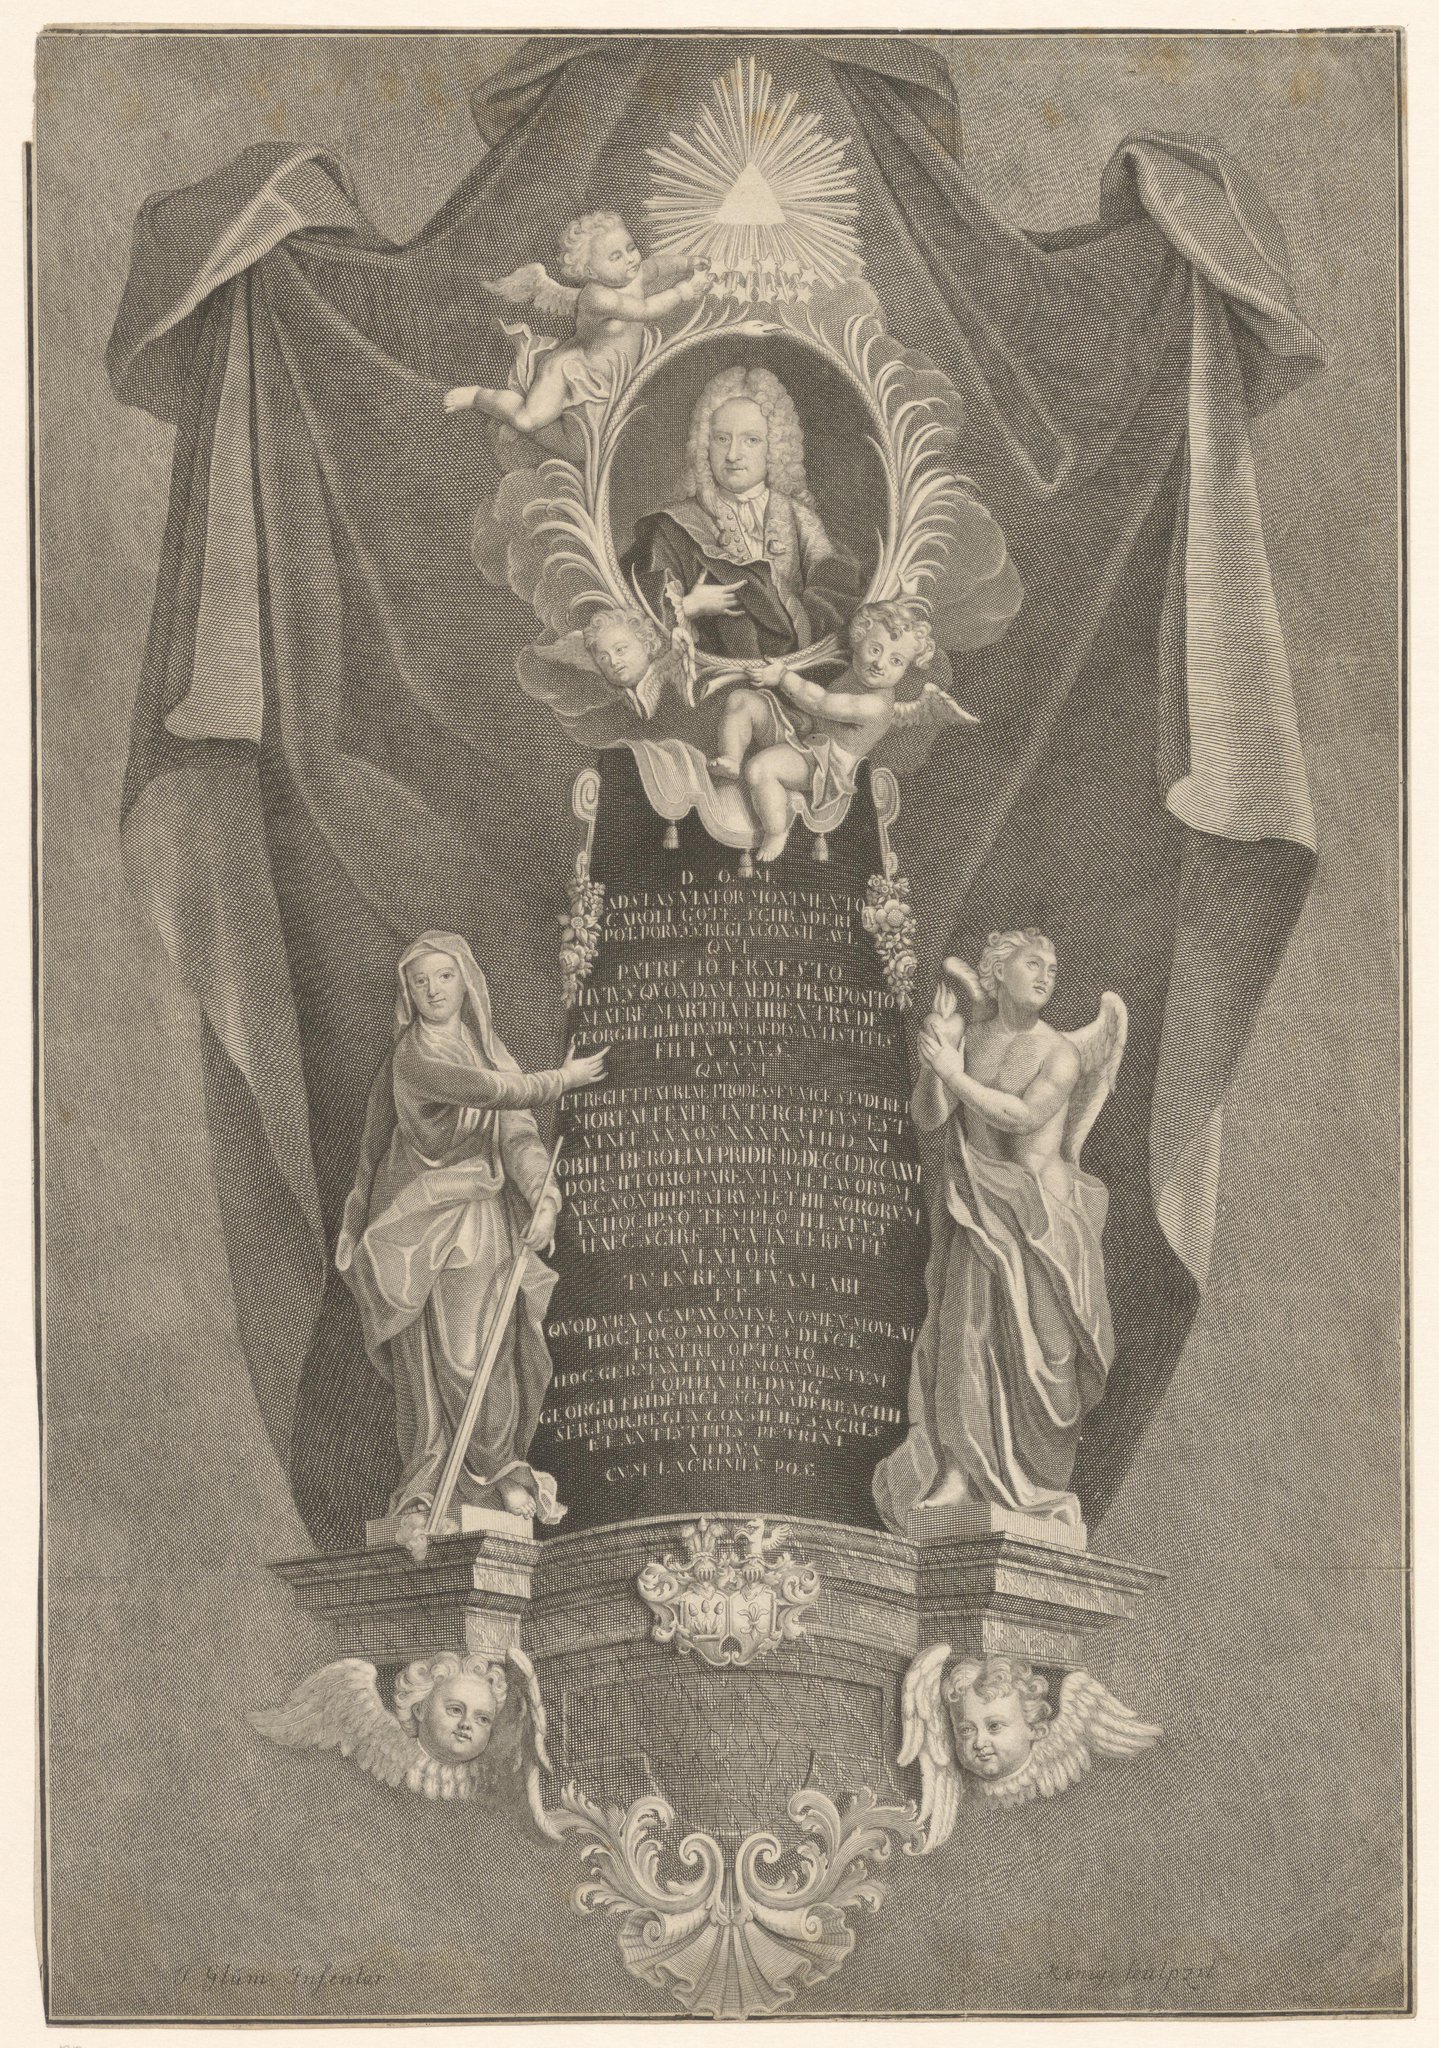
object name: print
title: Portret van Carl Gottfried Schrader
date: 1726-1752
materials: paper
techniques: engraving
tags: berlin, historical persons, physician, doctor (+ portrait of scholar, scientist), symbols of the trinity ~ circular and/or triangular forms or arrangements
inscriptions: collector's mark: Lugt 2228